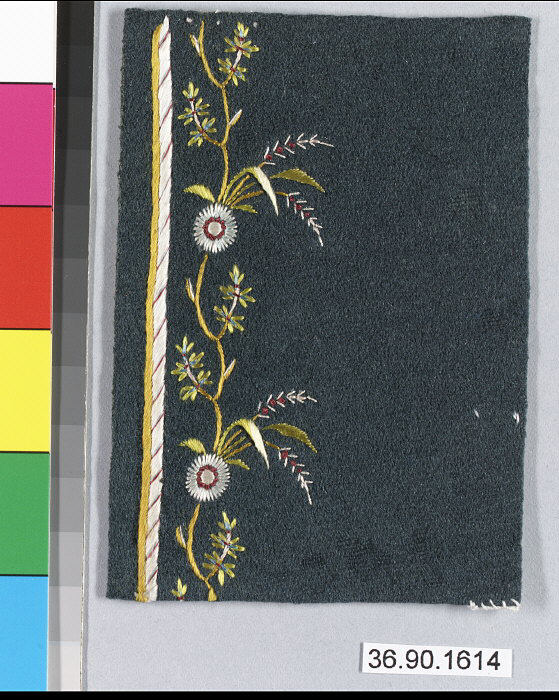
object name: sample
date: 1801-1833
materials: felt, silk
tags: flowers